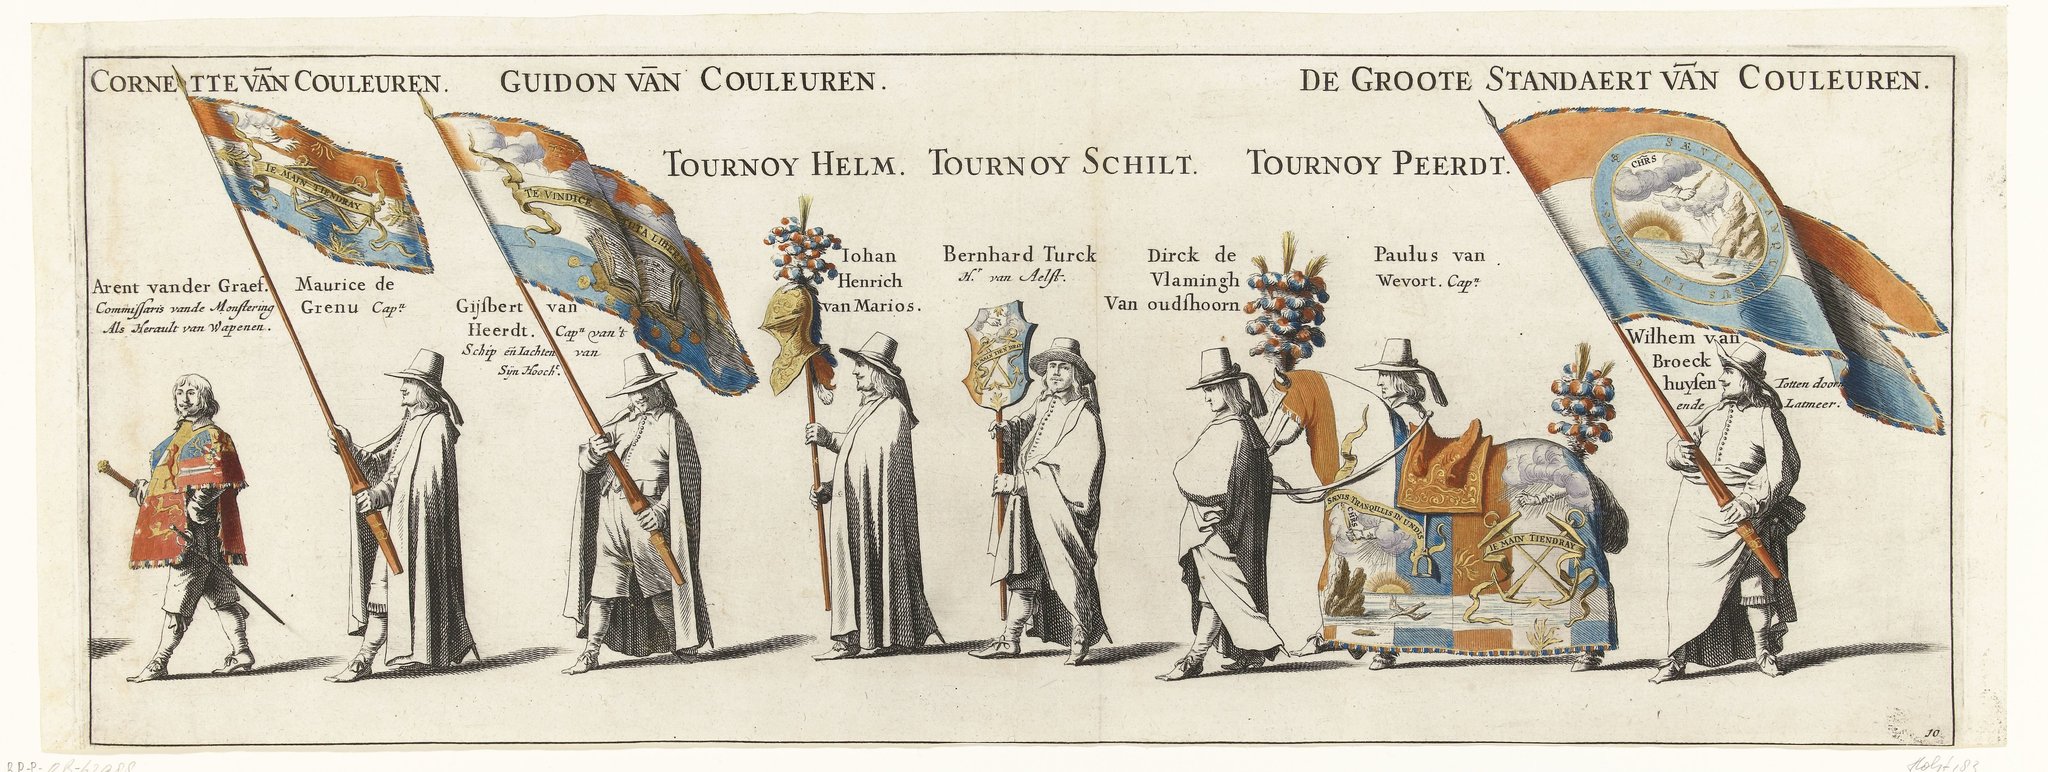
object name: print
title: De begrafenisstoet van Frederik Hendrik (plaat nr. 10), 1647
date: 1647-1651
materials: paper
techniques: etching, hand coloring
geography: amsterdam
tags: delft, the hague, frederick henry (prince of orange), cortege, funeral procession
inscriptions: collector's mark: Lugt 2228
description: De begrafenisstoet van stadhouder Frederik Hendrik te 's-Gravenhage op 10 mei 1647. Plaat nr. 10 met een deel van de stoet met vaandeldragers en een paard, boven de personen staan hun naam en functie. Onderdeel van een serie van 30 platen en 20 tekstbladen, bedoeld om aan elkaar geplakt te worden.